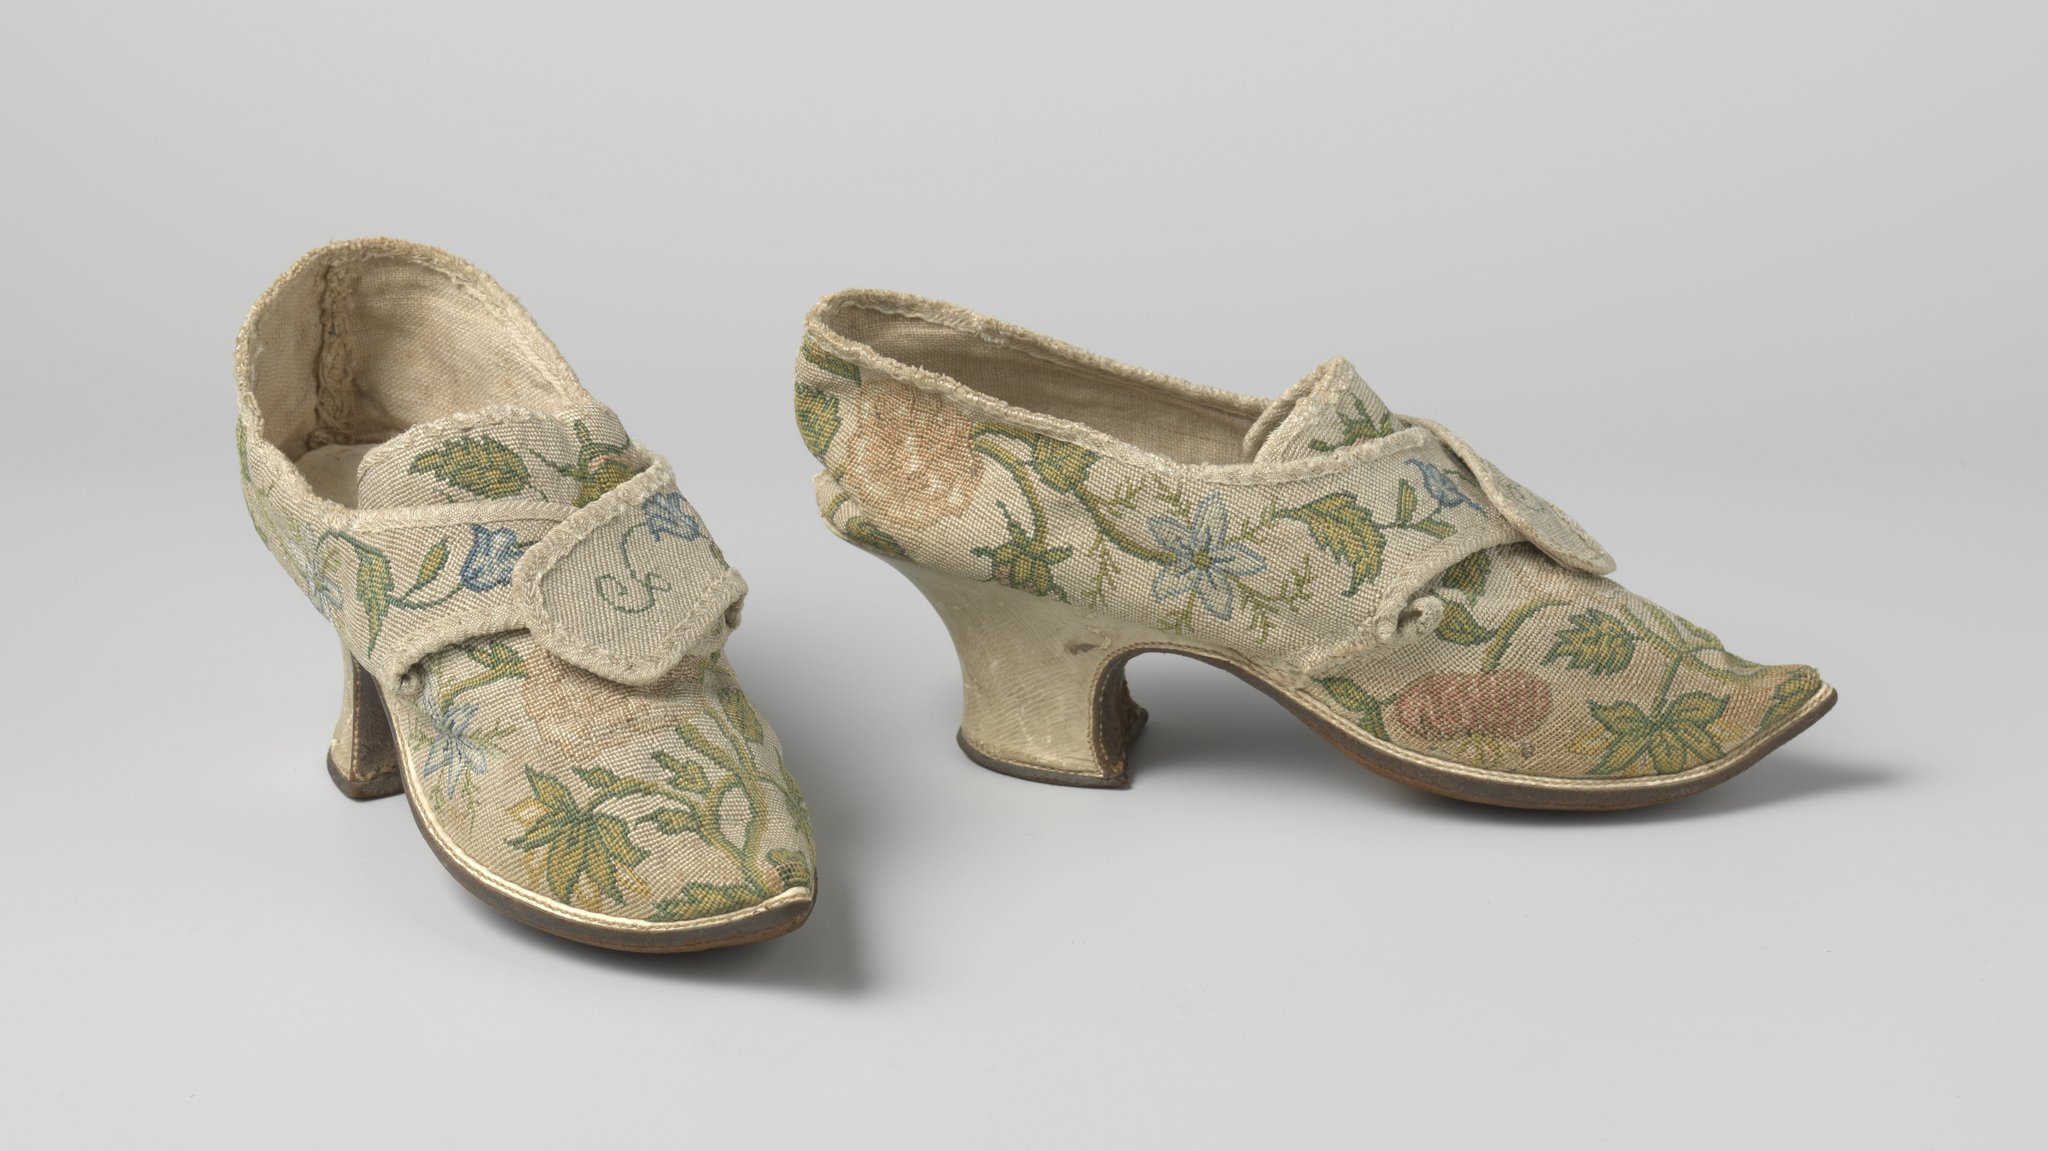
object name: womenswear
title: Schoen met blad, tong en flappen van linnen, in petit point geborduurd met floraal motief van veelkleurige zijde; puntige neus en halfhoge hakken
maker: Anonymous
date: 1700-1725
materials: leather, linen, silk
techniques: embroidered, petit point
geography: netherlands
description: Model: schoen met opwippende, puntige neus en halfhoge hakken. Blad van linnen, gevoerd met grof linnen. De tong verdwijnt bijna geheel onder de twee over elkaar liggende flappen, die oorspronkelijk met een schoengesp werden gesloten. Tussen blad en zool een doorgestikte rand van hetzelfde witte geitenleer waar ook de hak mee bekleed is. Binnenzool van wit geitenleer. Versiering: het blad, de tong en de flappen zijn met veelkleurige zijde in petit point geborduurd met een floraal motief bestaande uit granaatappel (?), roos, vergeet-mij-niet, ranken met bladeren, roze-rode en blauwe bloemen.